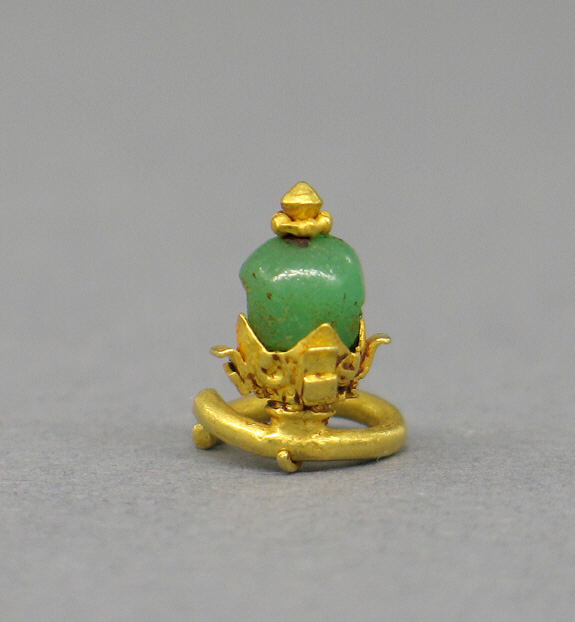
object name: ear clip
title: Pair of Ear Clips with Bead in Four-Prong Lotus Base Setting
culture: indonesian, javanese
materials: gold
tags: lotuses